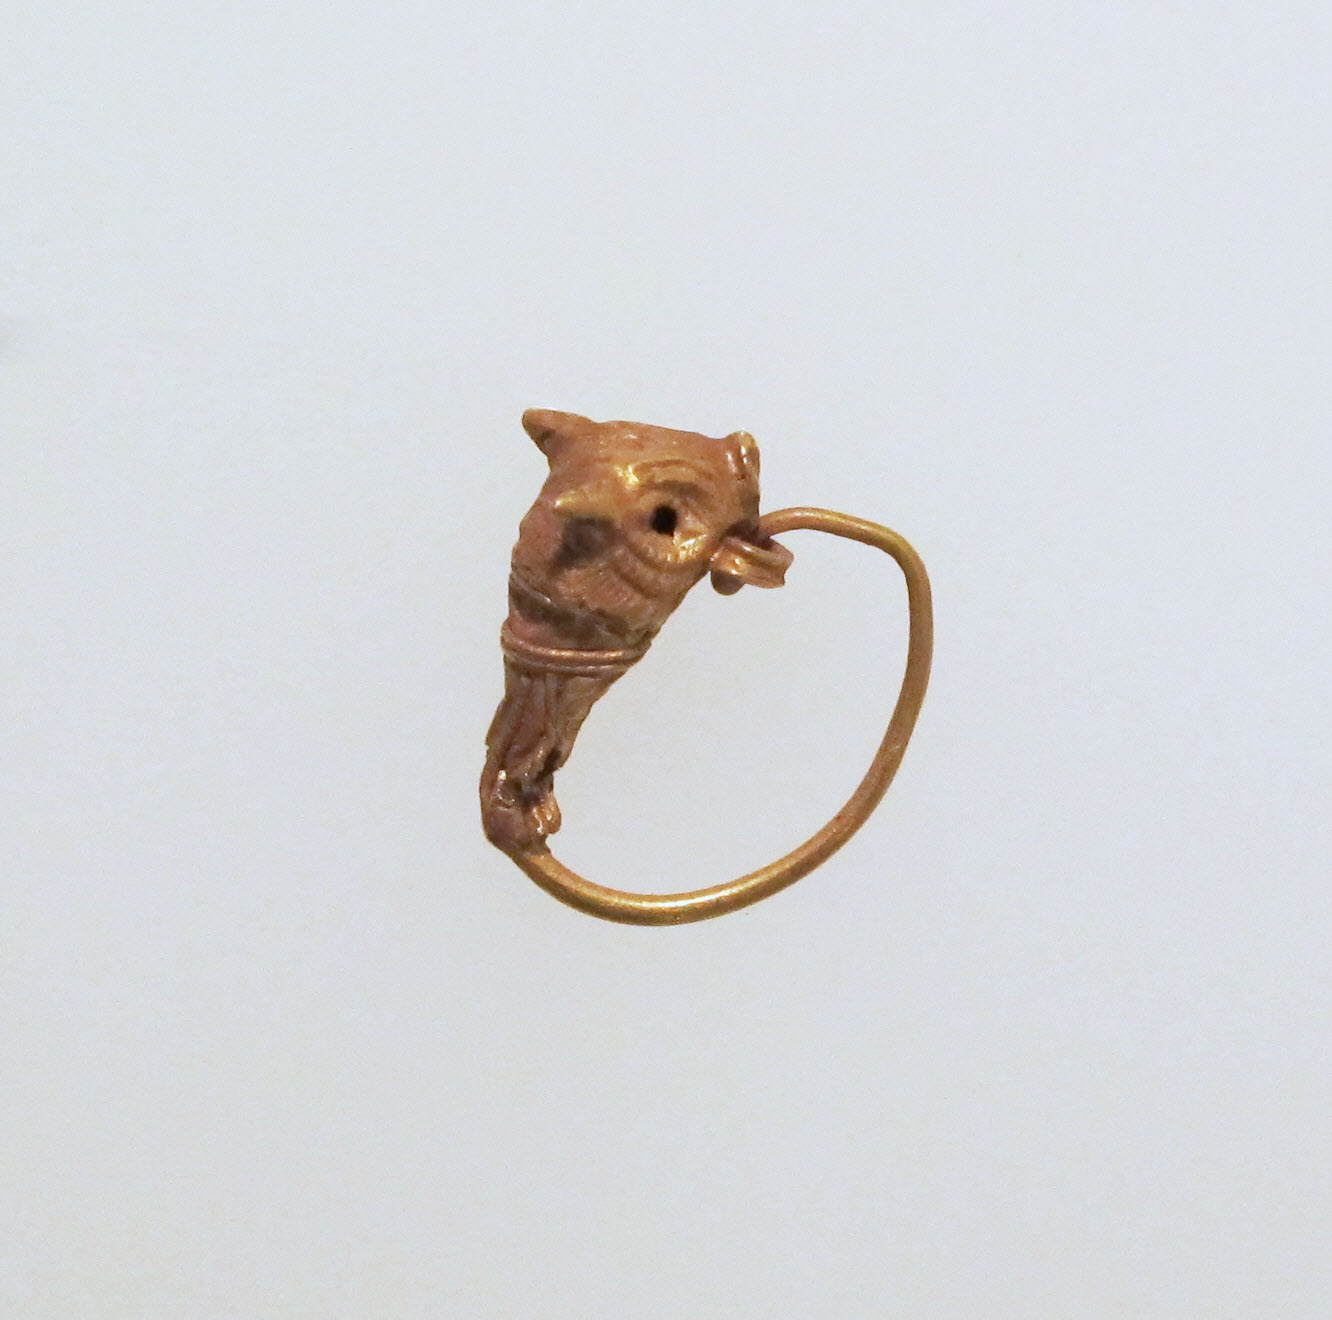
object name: earring with head of bull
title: Gold earring with head of a bull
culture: greek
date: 400-201 BCE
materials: gold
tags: bulls